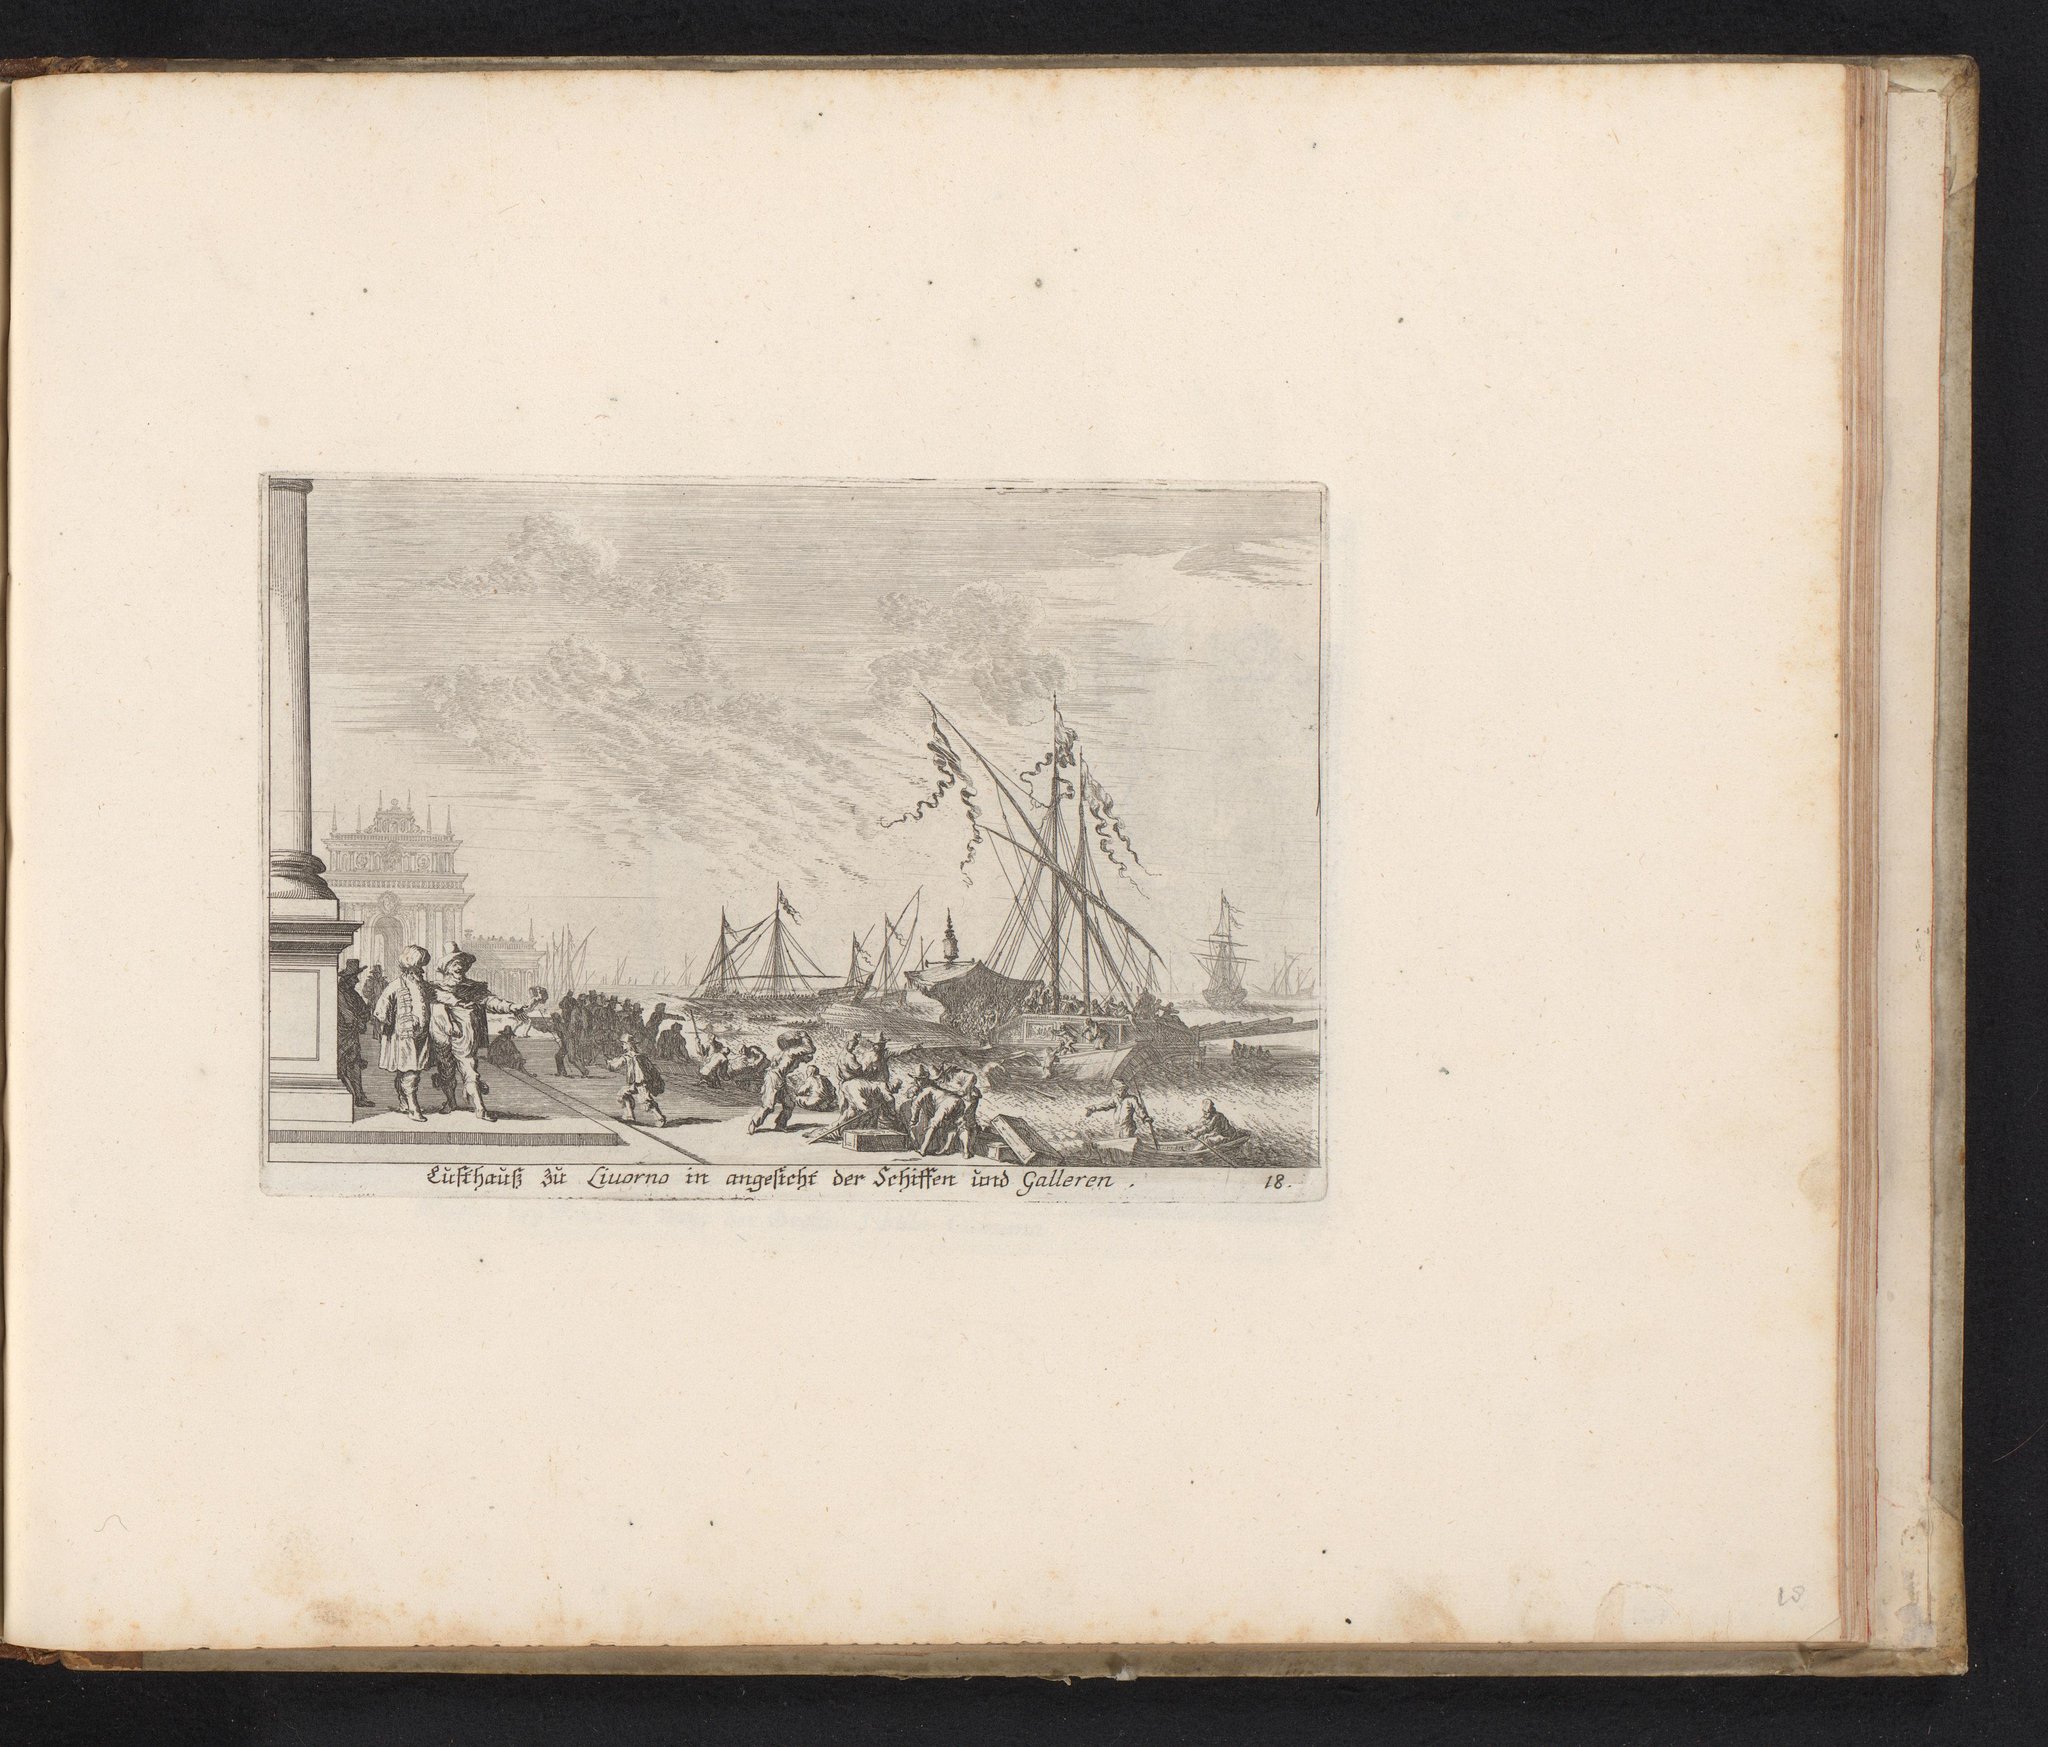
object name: print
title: Haven van Livorno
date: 1670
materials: paper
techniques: etching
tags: harbour (+ number of persons ~ traffic and transport)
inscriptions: collector's mark: Lugt 2228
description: Tekst in het Duits in de ondermarge. Rechtsonder genummerd: 18. Prent maakt deel uit van een album.